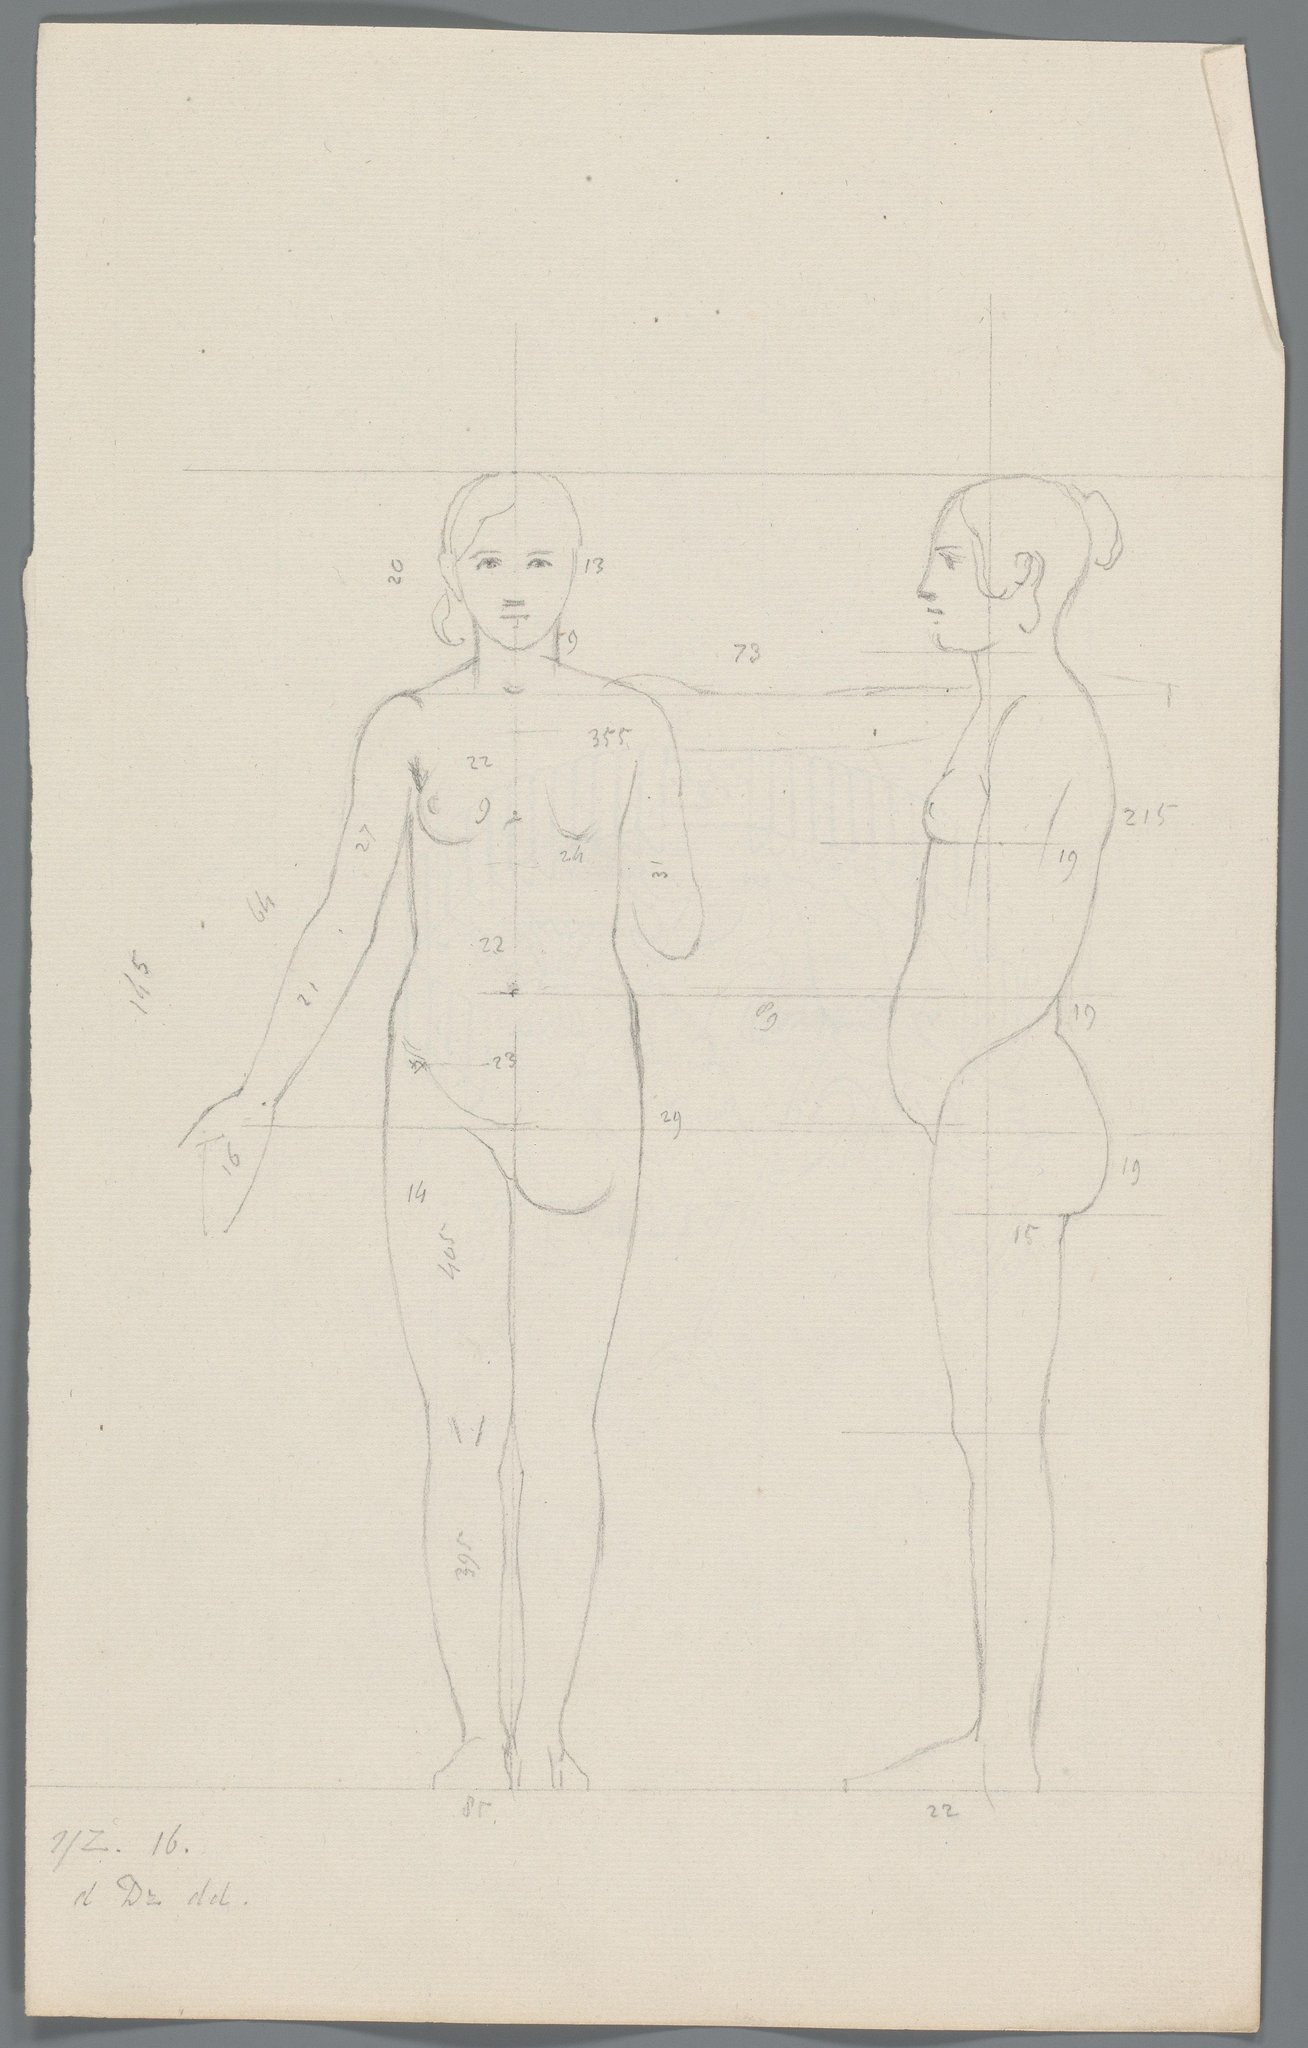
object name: drawing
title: Proportiestudie van een vrouw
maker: jacobus everhardus josephus van den berg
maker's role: draughtsman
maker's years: 1802-1861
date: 1812-1861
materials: paper, pencil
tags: standing figure (canon, proportions) - aa - female human figure, anatomy (non-medical) - aa - female human figure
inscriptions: inscription: ‘YZ. 16./ d Dz dd.’